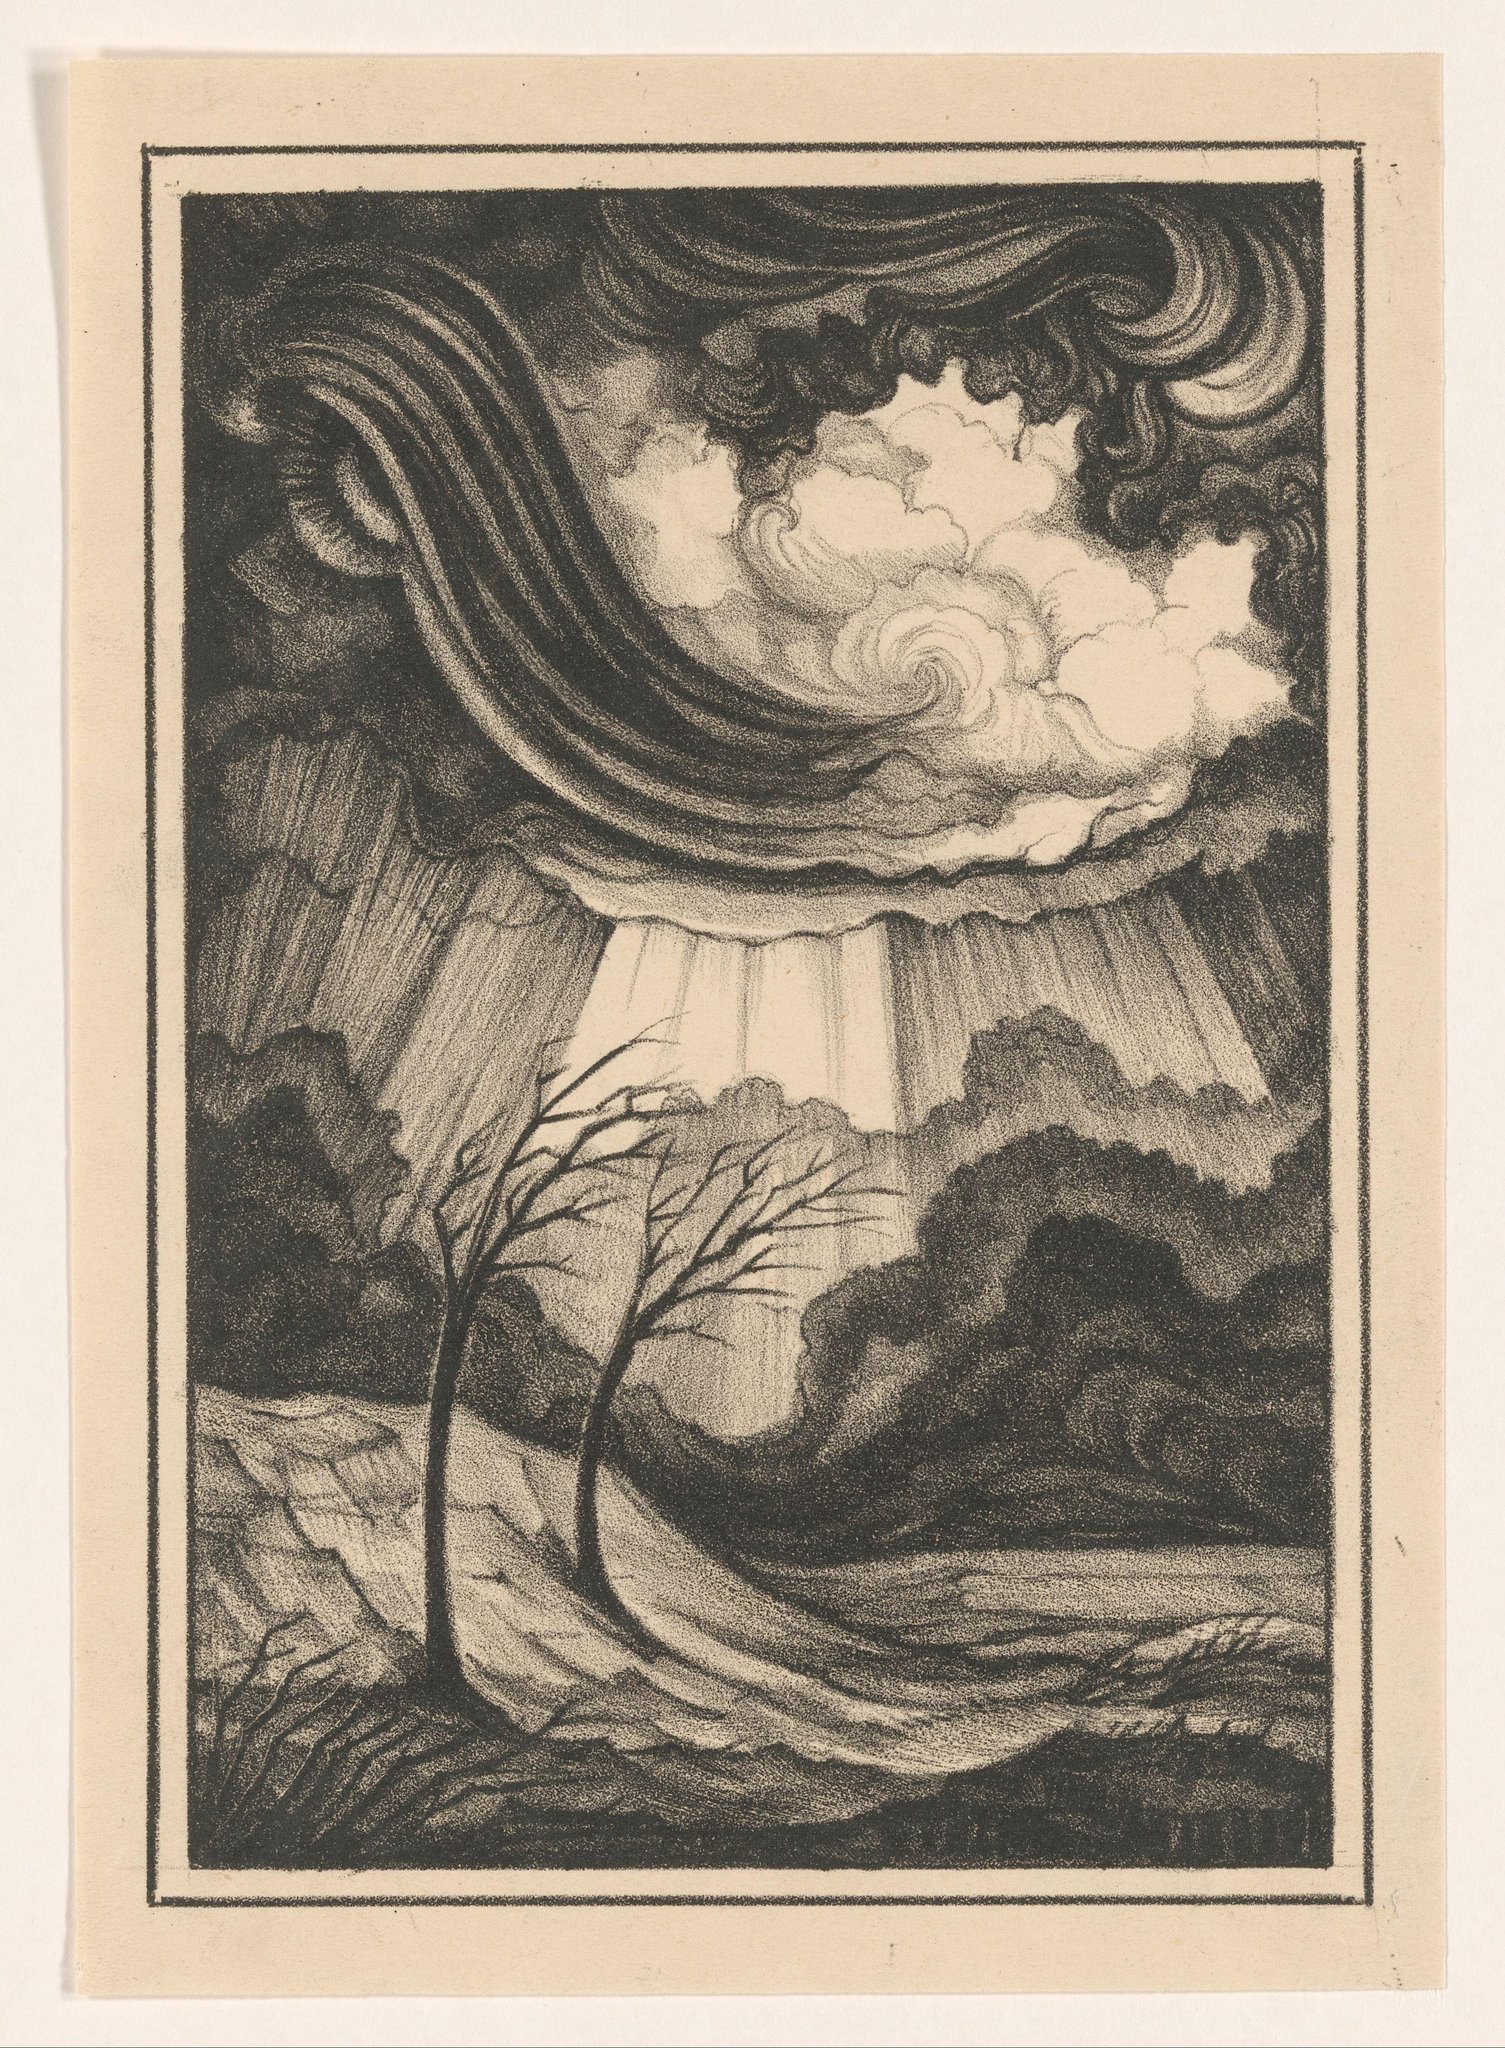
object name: print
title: Landschap met kale bomen en wolkenlucht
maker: henk schilling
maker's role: print maker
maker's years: 1893-1942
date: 1903-1920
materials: paper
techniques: lithograph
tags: clouds, landscapes in the temperate zone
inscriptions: collector's mark: Lugt 2233